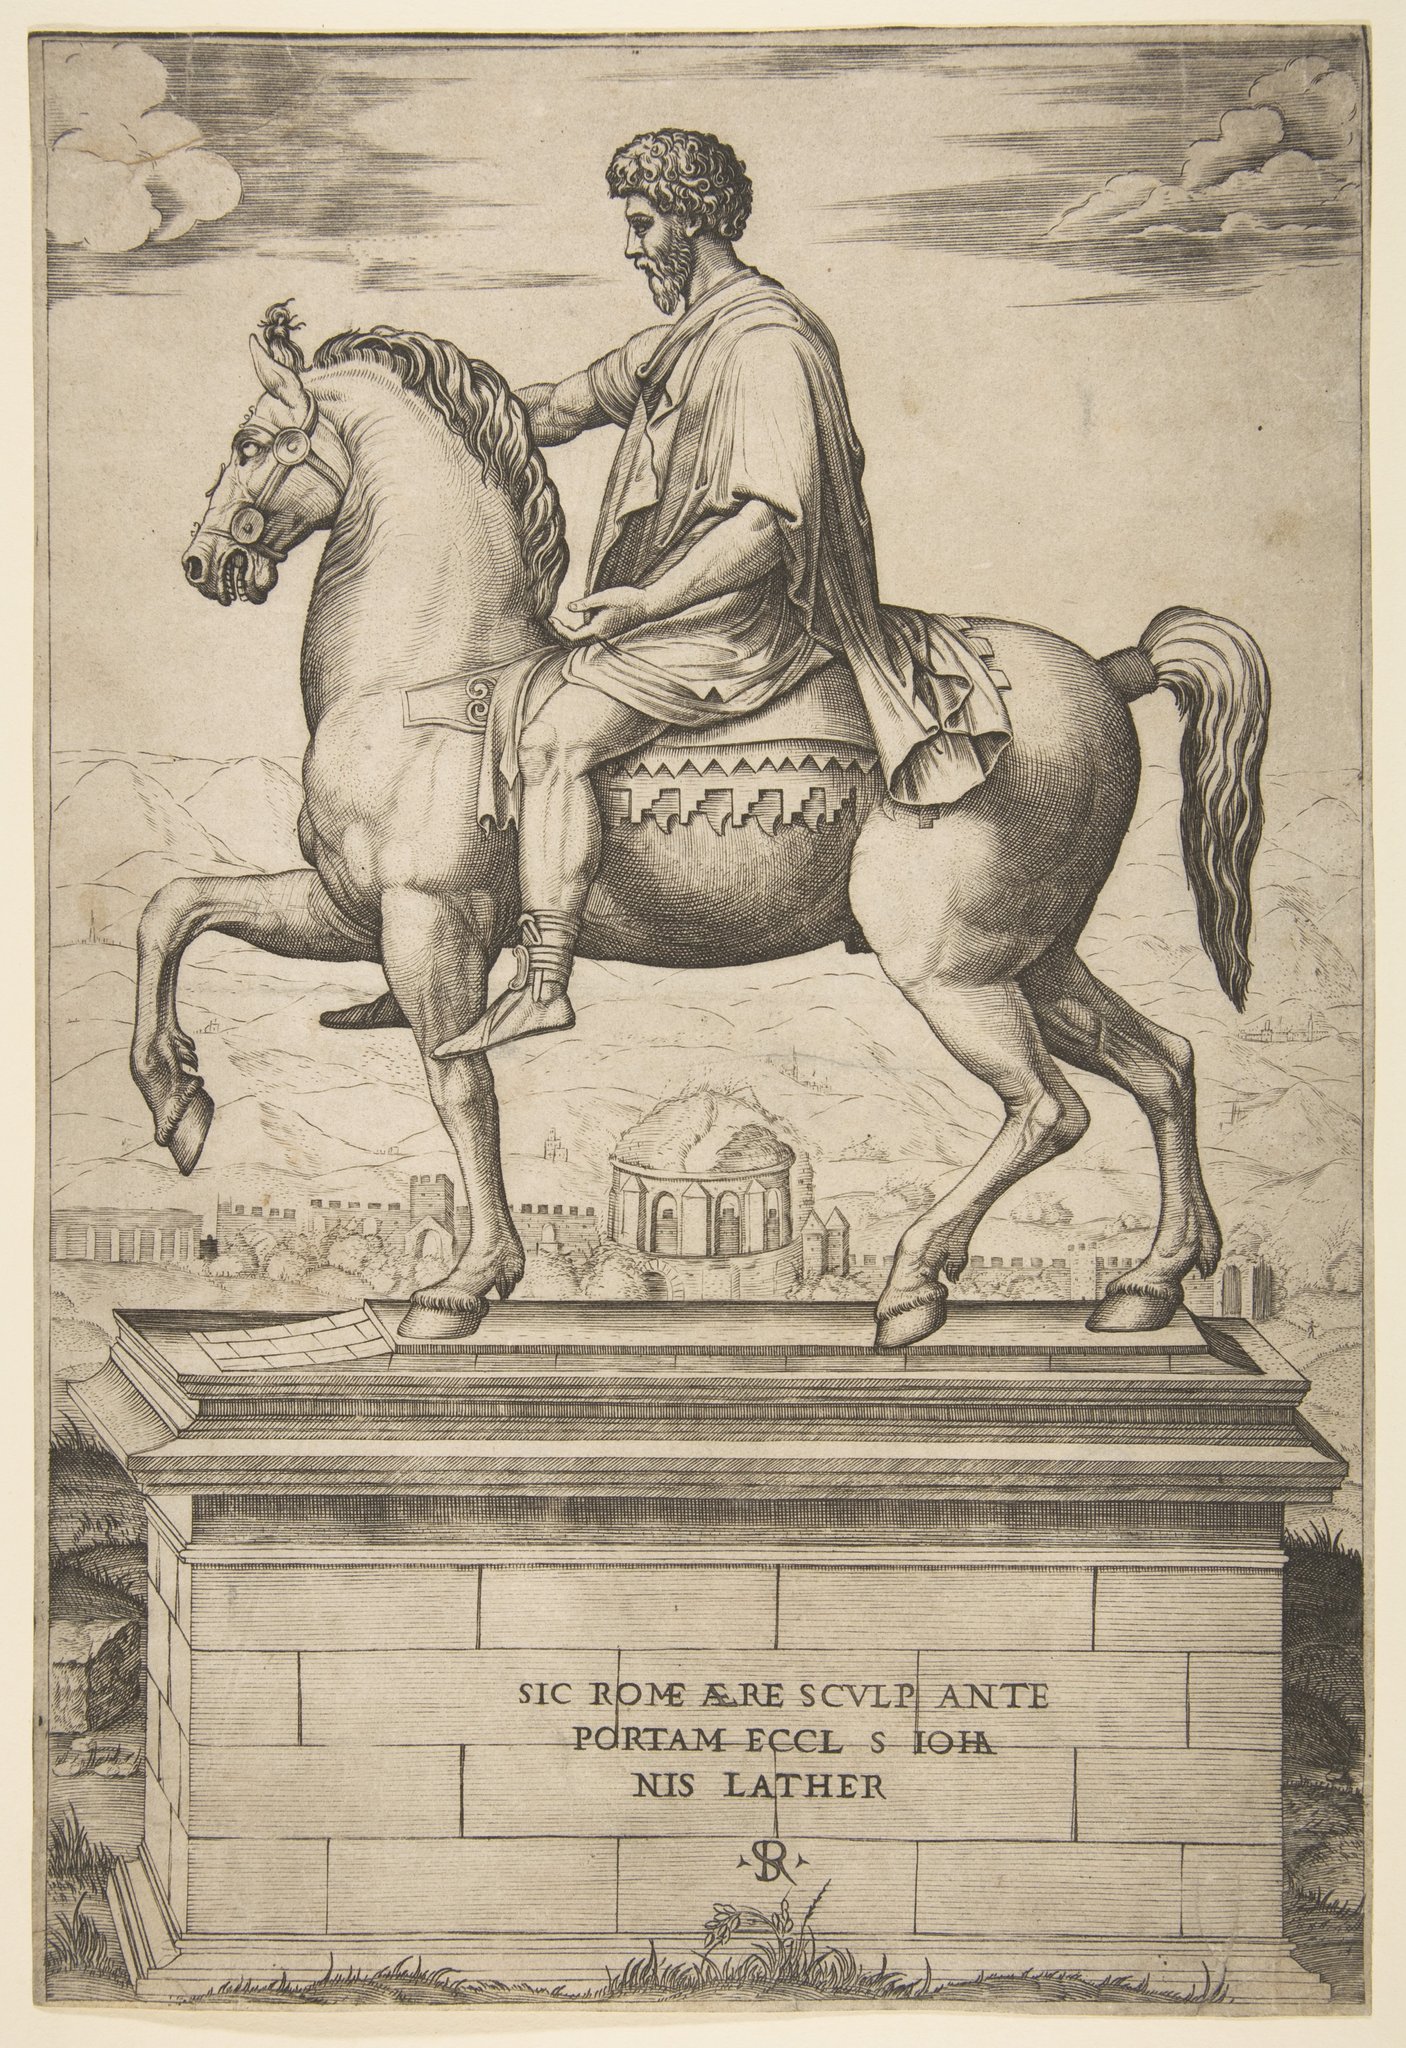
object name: print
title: Equestrian Statue of Marcus Aurelius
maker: marco dente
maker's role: artist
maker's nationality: italian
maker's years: 1515-1527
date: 1515-1527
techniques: engraving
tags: sculpture,men,horses